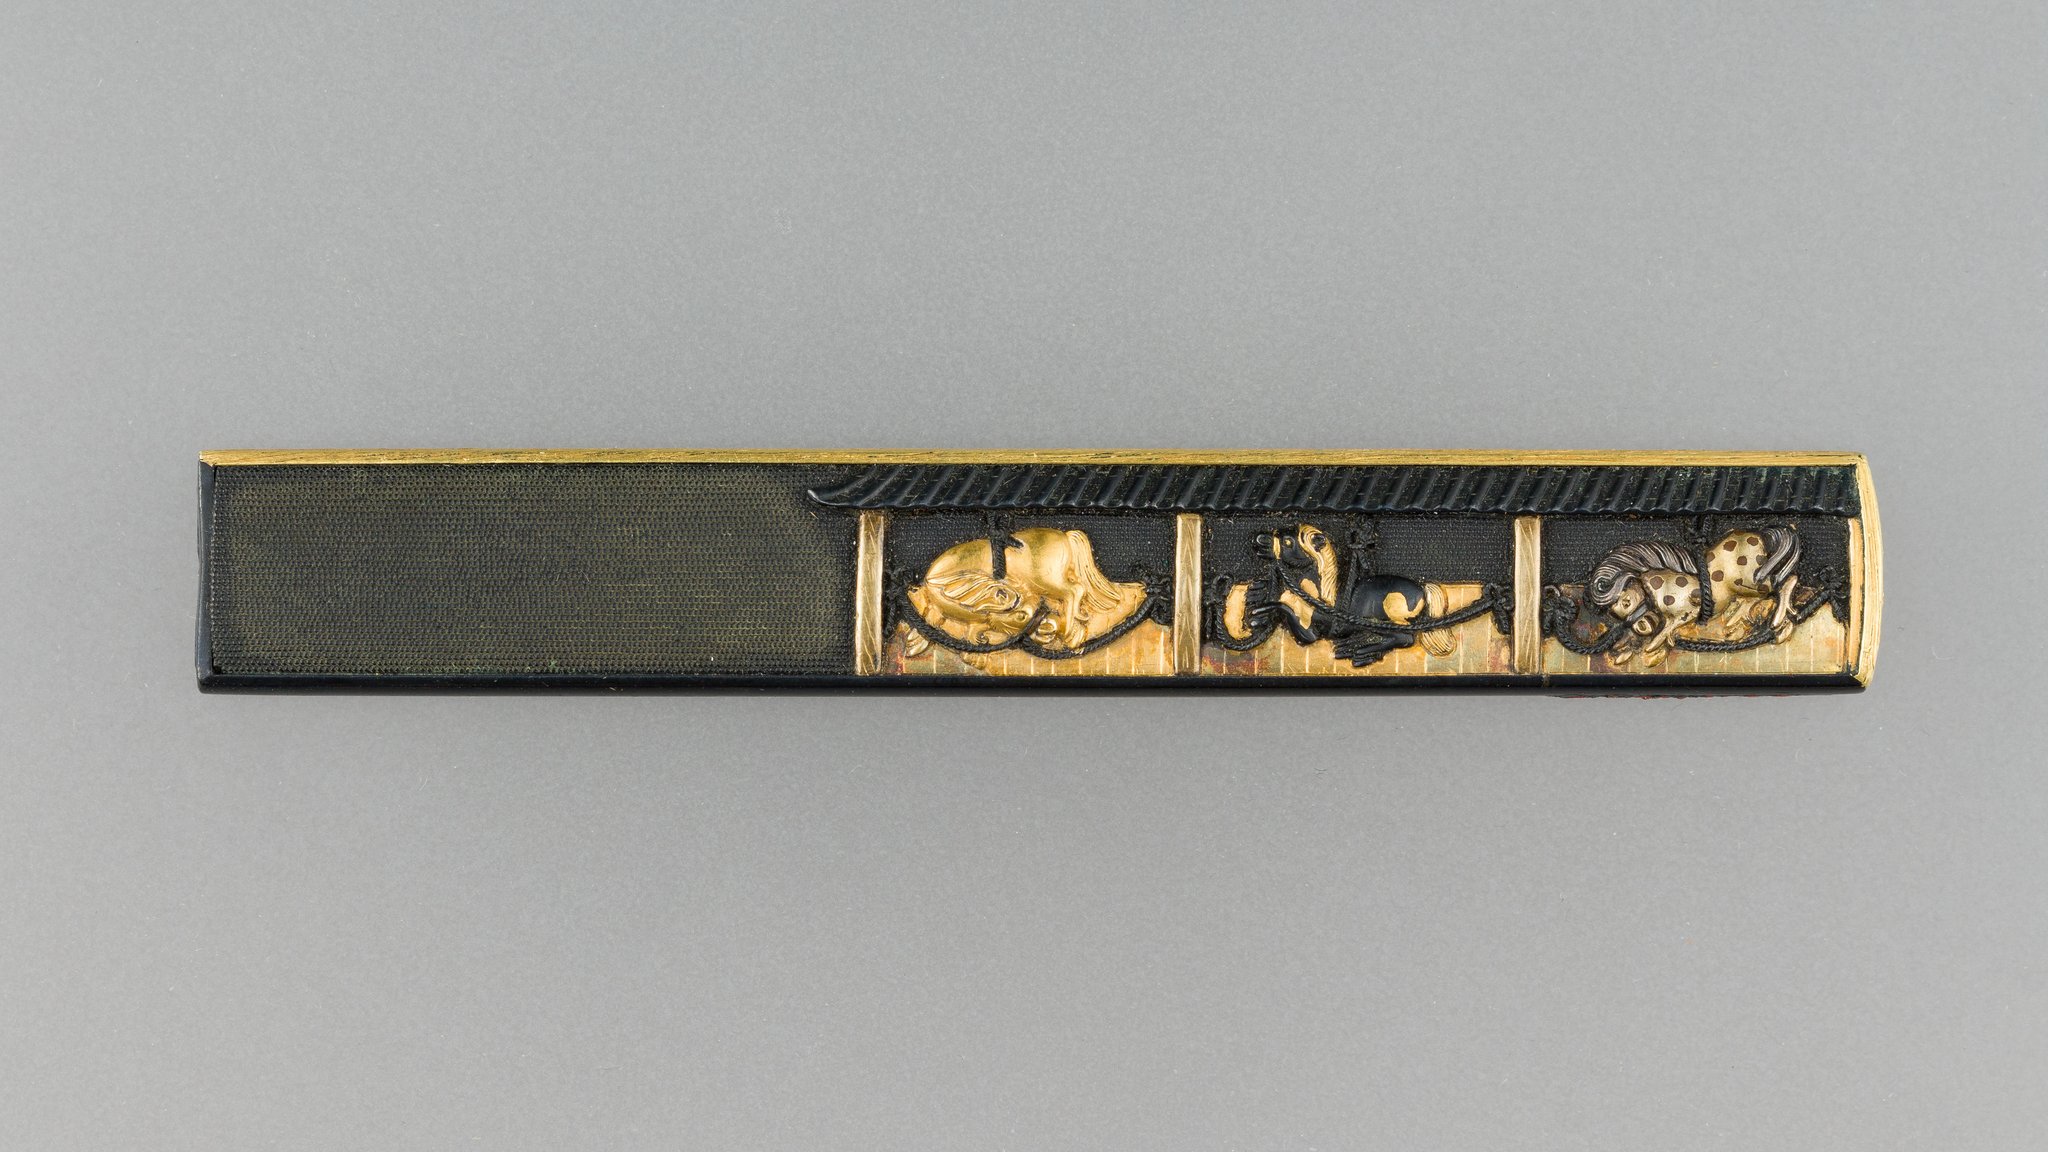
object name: knife handle kozuka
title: Knife Handle (Kozuka)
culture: japanese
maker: gotō mitsunori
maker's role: maker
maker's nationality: japanese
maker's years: 1646-1712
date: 1701-1733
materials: gold alloy, gold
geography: japan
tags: horses